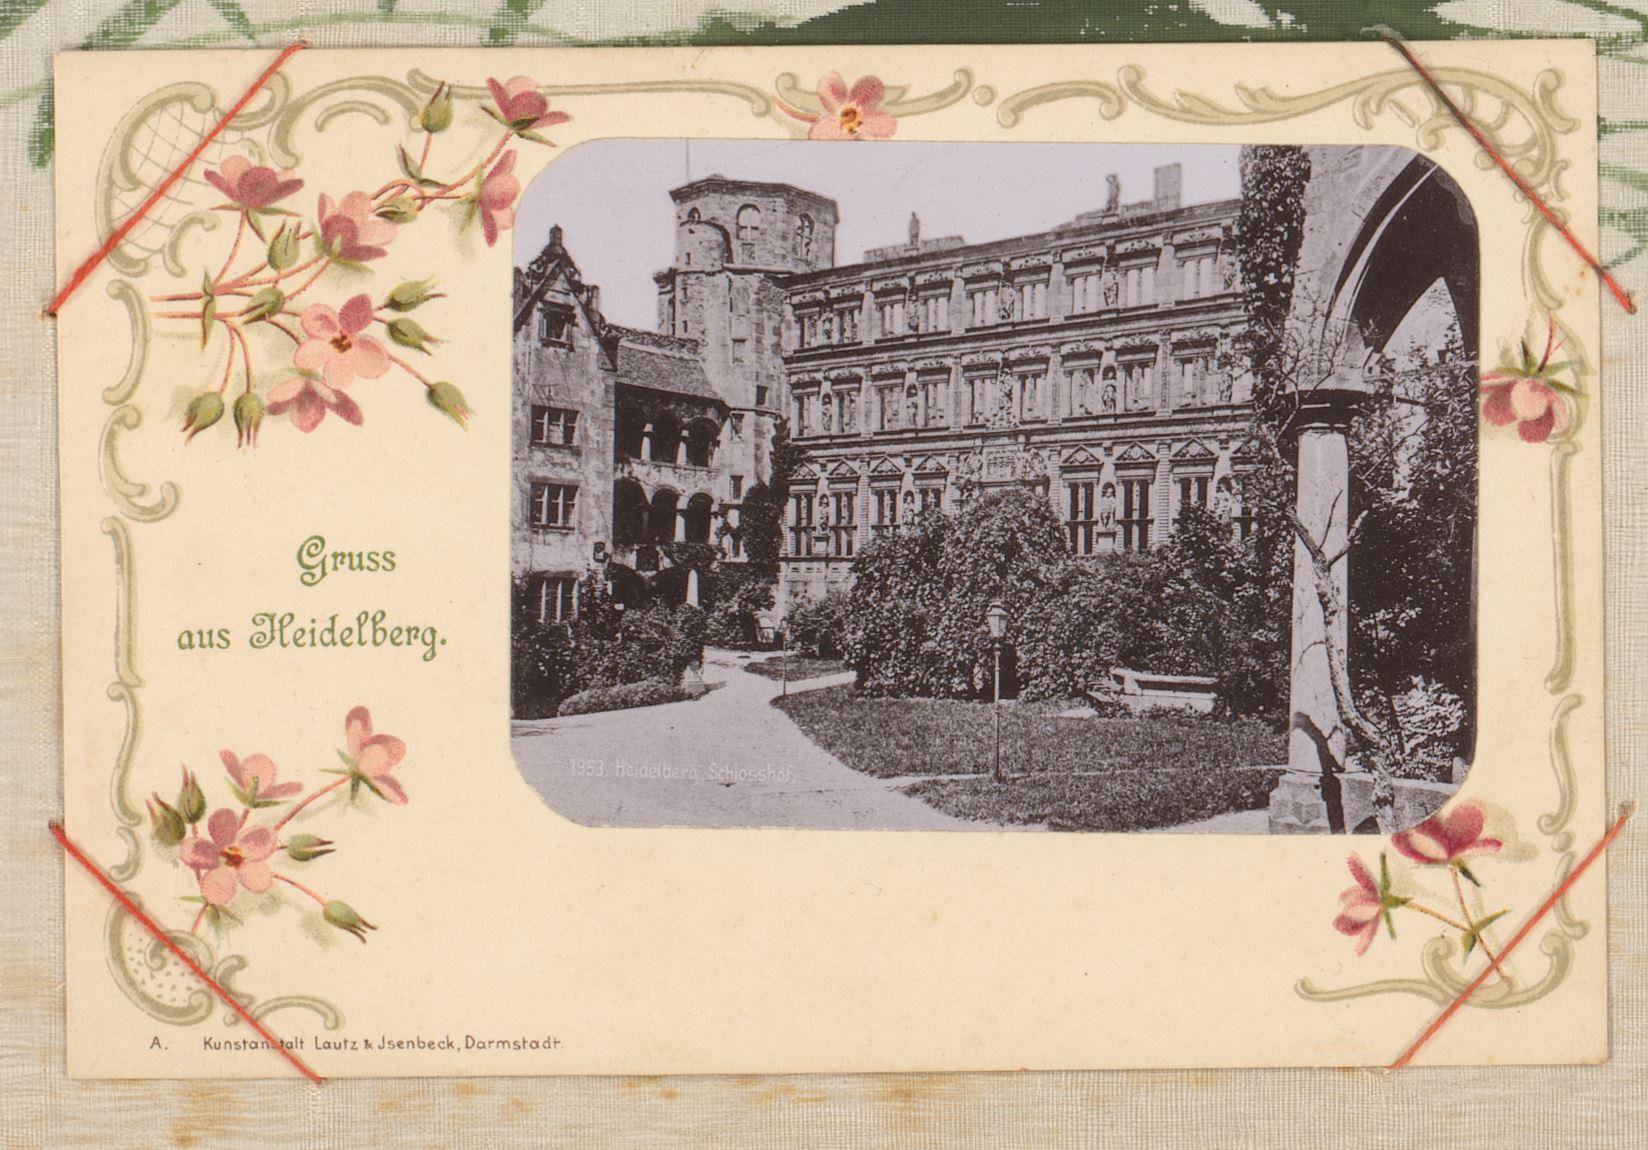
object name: photomechanical print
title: Gruss aus Heidelberg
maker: Anonymous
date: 1880-1910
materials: cardboard, paint, paper, silk, textile, watercolor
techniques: brush, chromolithography, photograph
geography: heidelberg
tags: ruin of a dwelling, house, castle, etc.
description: Deze prent maakt deel uit van een album.